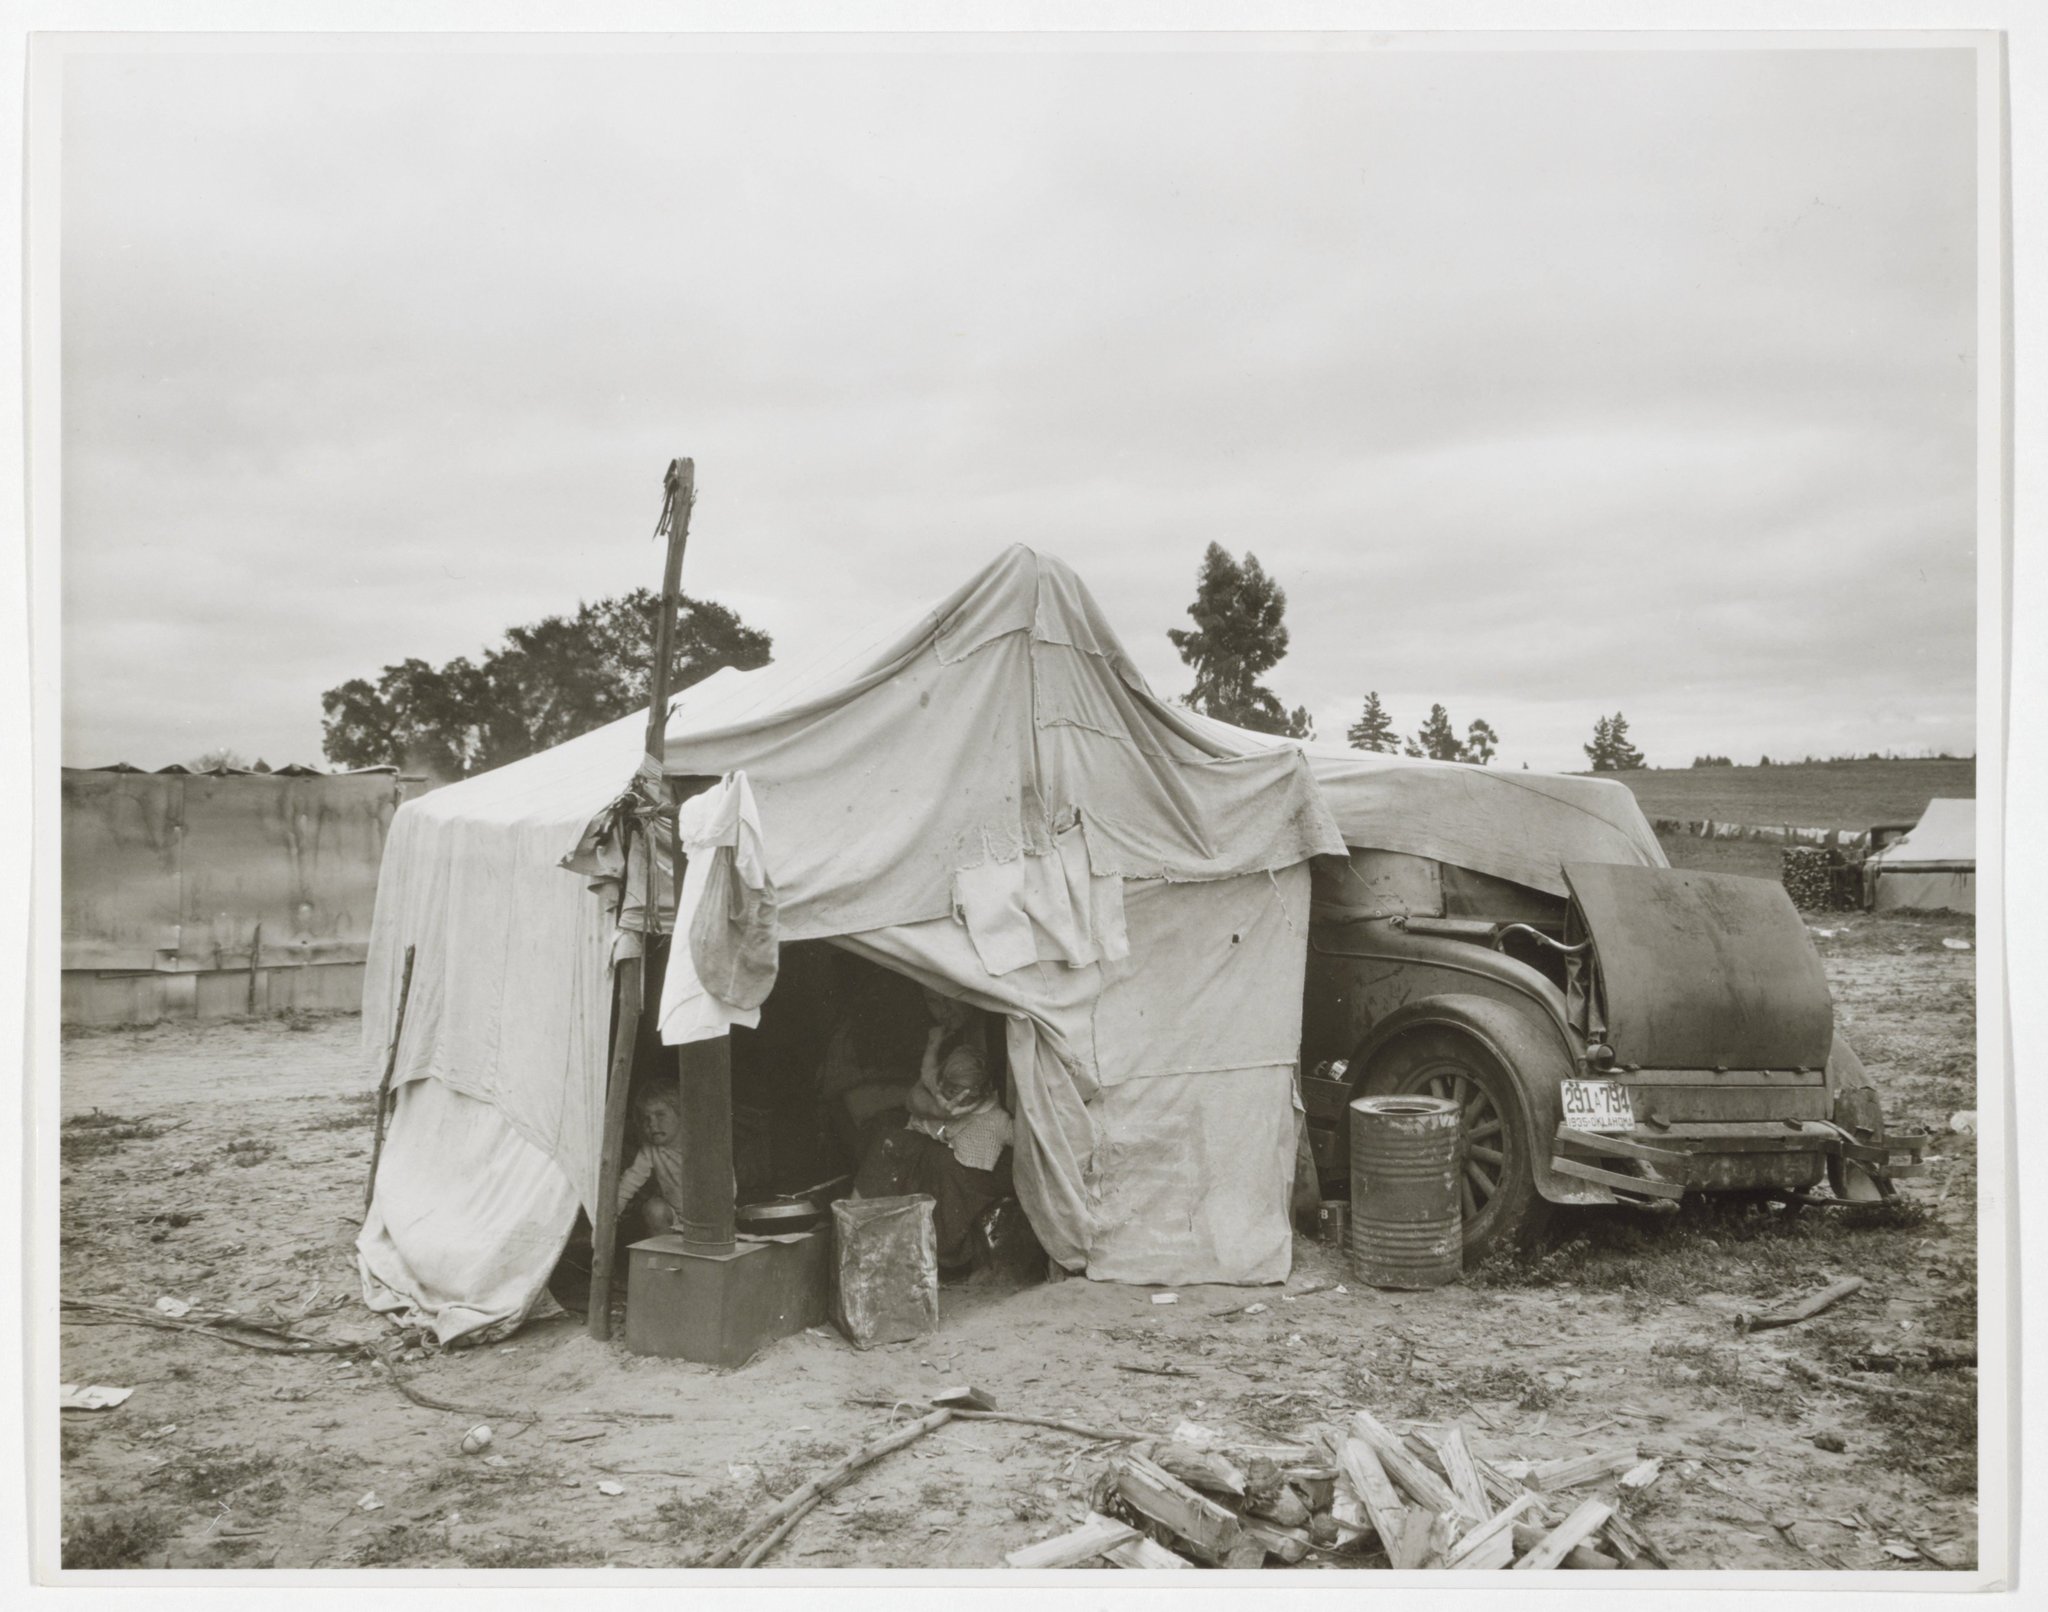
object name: photograph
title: Cotton Pickers’ Camp, Nipomo California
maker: dorothea lange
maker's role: fotograaf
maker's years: 1895-1965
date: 1902-1936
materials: paper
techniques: gelatin silver print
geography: california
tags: tent, wandering communities living in tents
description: A young cotton picker in the grim years of the Great Depression. Lange was originally a portrait photographer, as is clear to see. In the 1930s she recorded the working and living conditions in rural America for the Farm Security Administration. In search of work, entire families migrated throughout the country, living in tents, shacks, and automobiles.